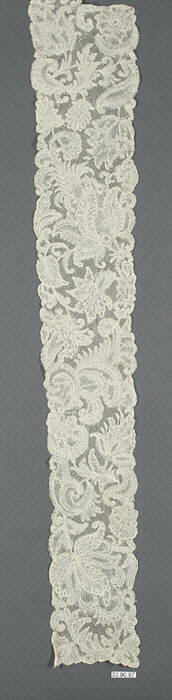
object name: lappet and cap edging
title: Lappets and cap edging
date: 1701-1733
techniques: lace